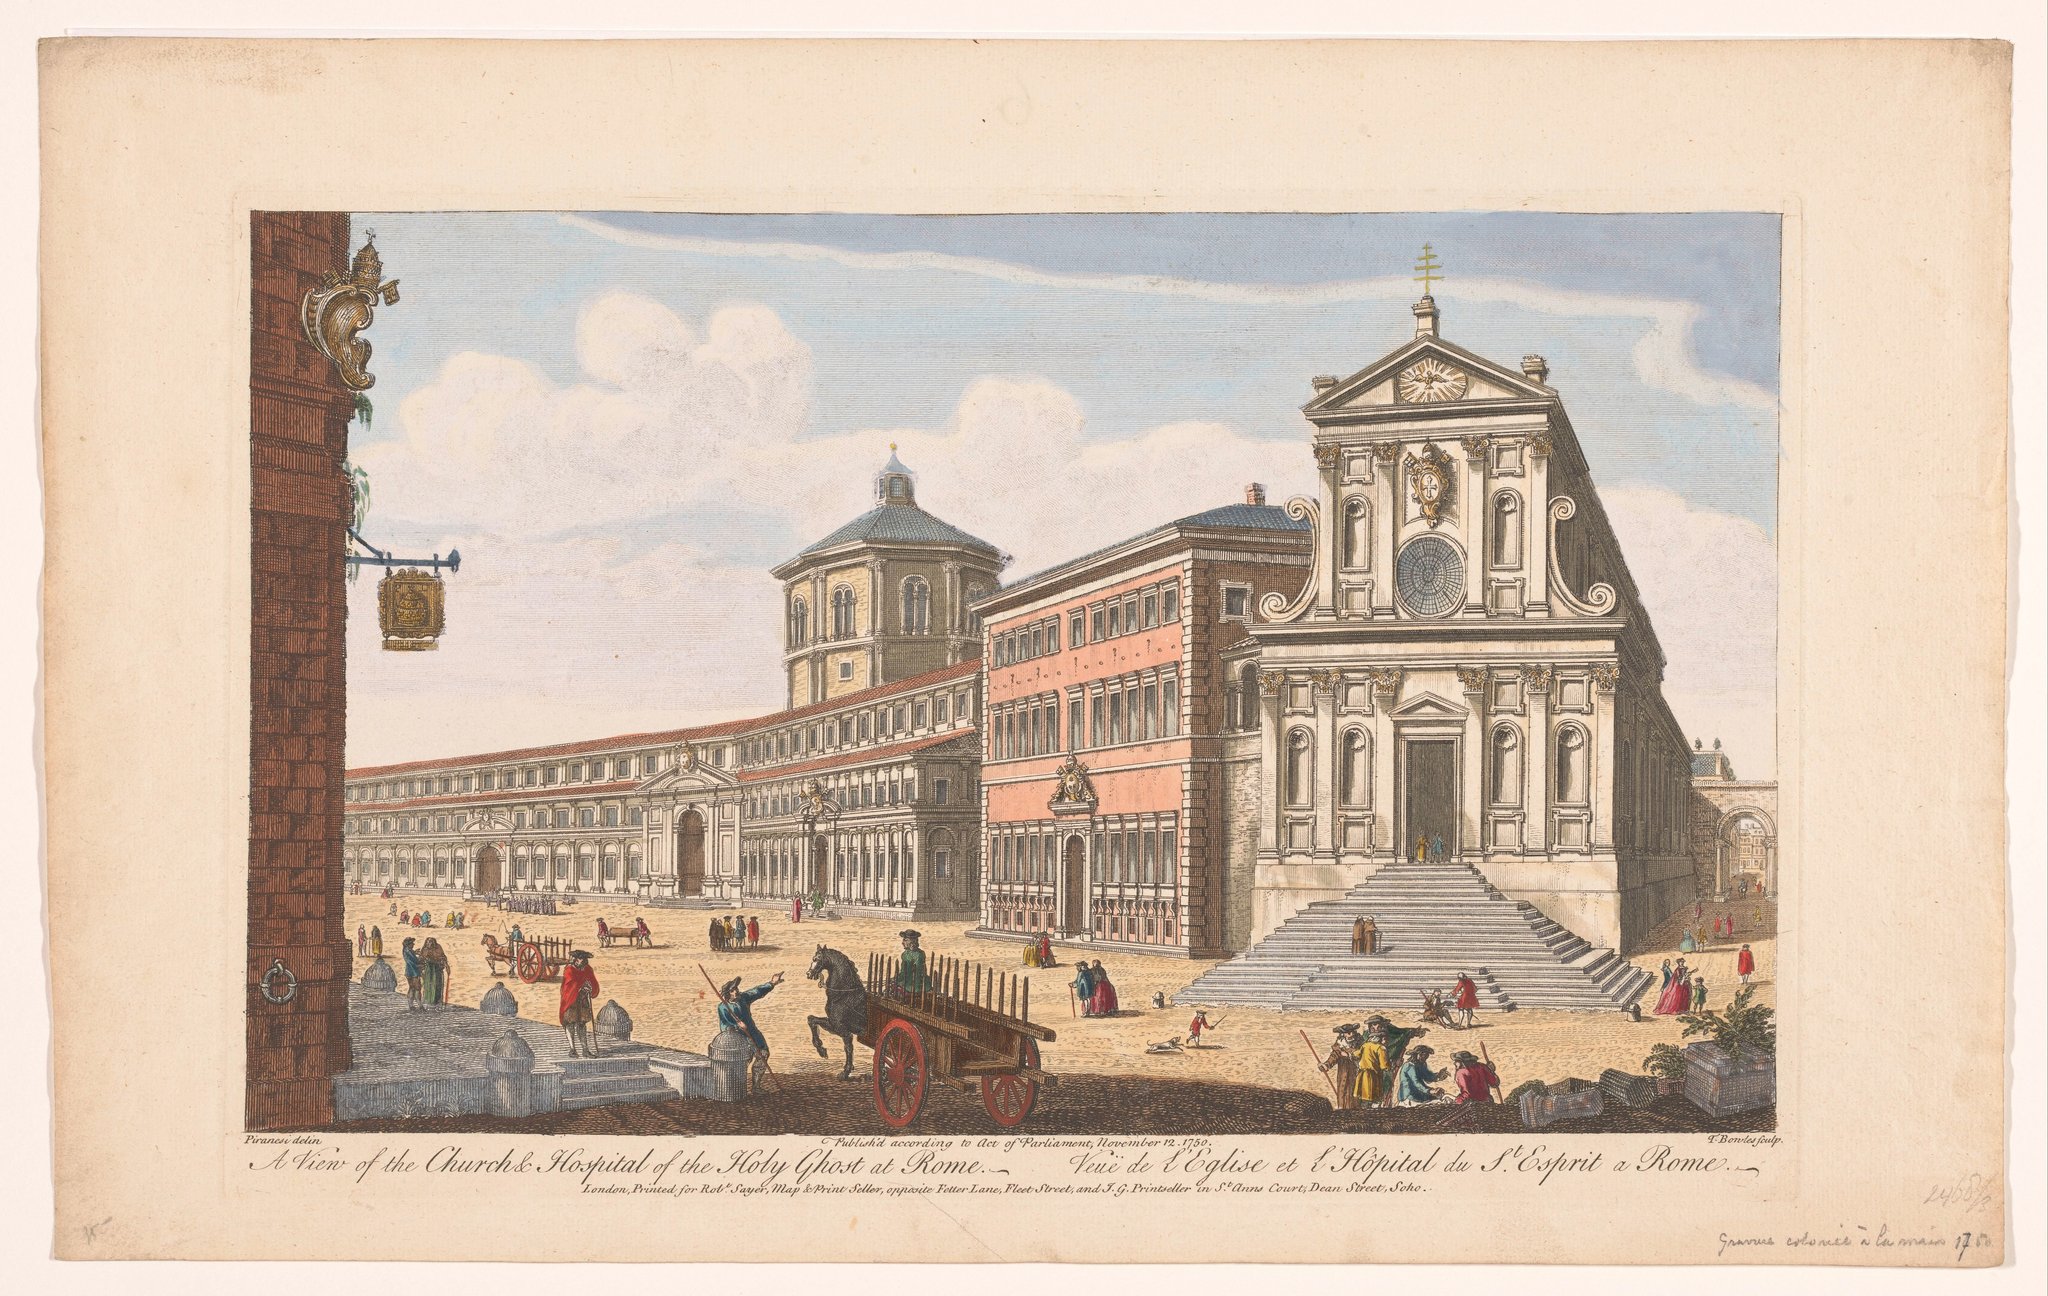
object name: opticaprent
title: A view of the Church & Hospital of the Holy Ghost at Rome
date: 1750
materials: paper, watercolor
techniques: brush, etching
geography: london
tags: church (exterior), street (+ city(-scape) with figures, staffage)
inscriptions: collector's mark: Lugt 2760, watermark:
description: De serie “Rome” bevat twaalf prenten met de nummers 1-12, waarvan dit nummer 3 is.